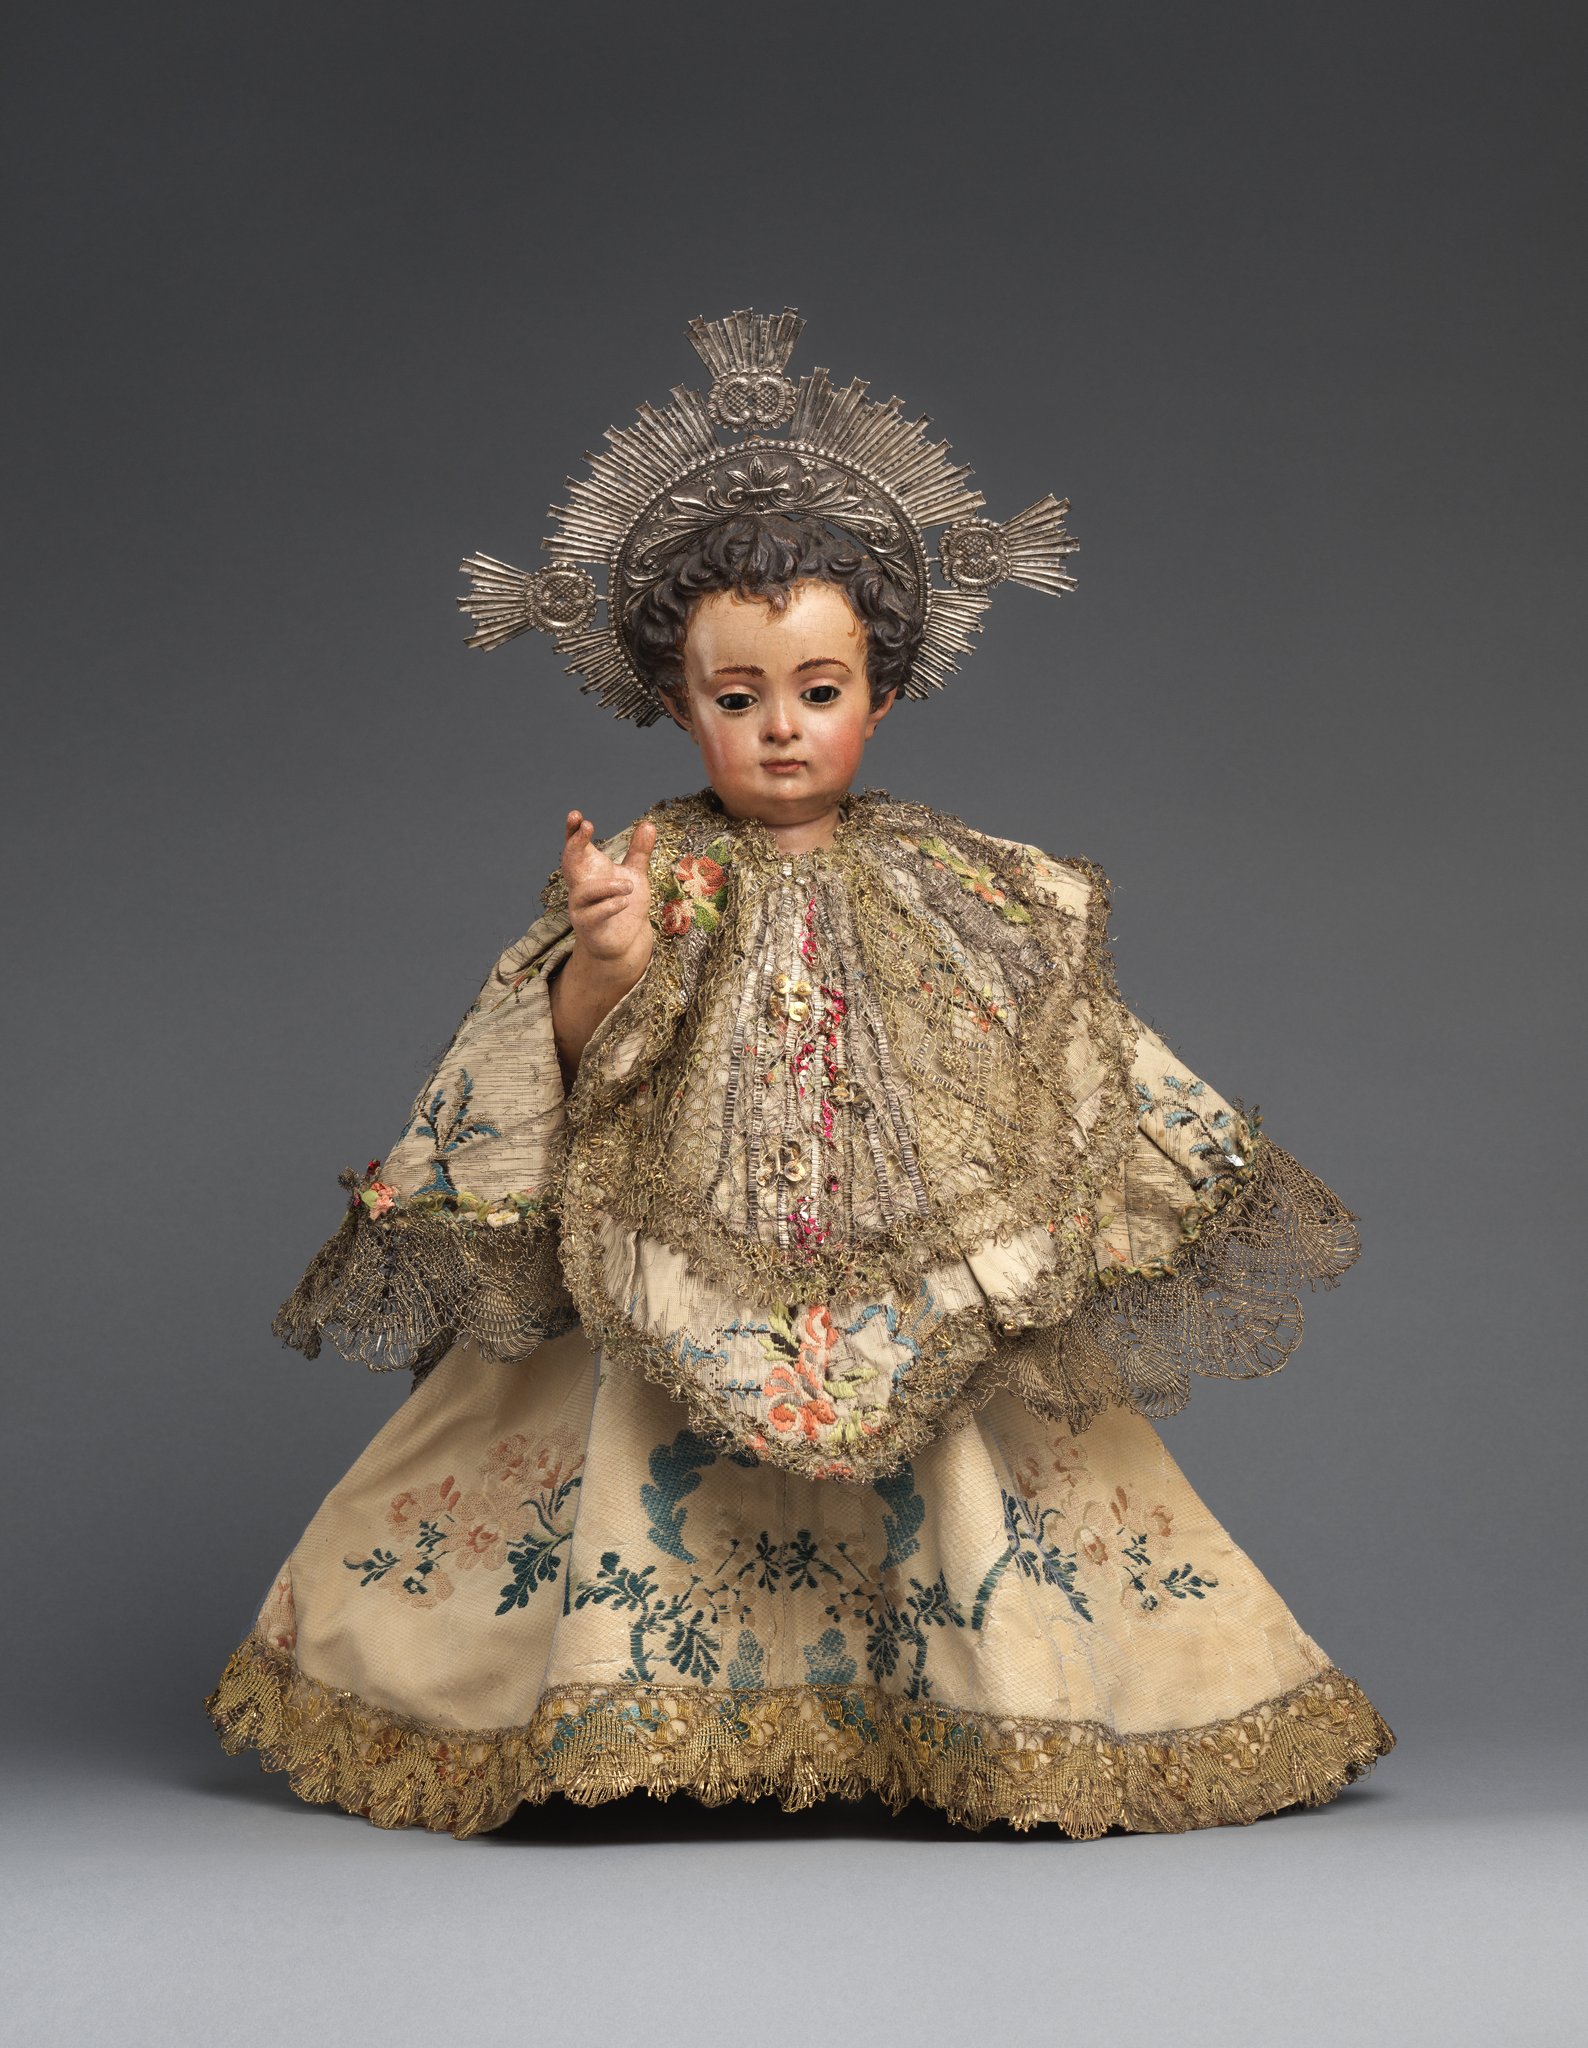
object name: statuette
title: The Child Jesus Triumphant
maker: juan de mesa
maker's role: maker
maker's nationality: spanish, andalusian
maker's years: 1583-1627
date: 1625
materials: glass, lace, lead, silk, silver, silver gilt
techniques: polychrome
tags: leaves,jesus